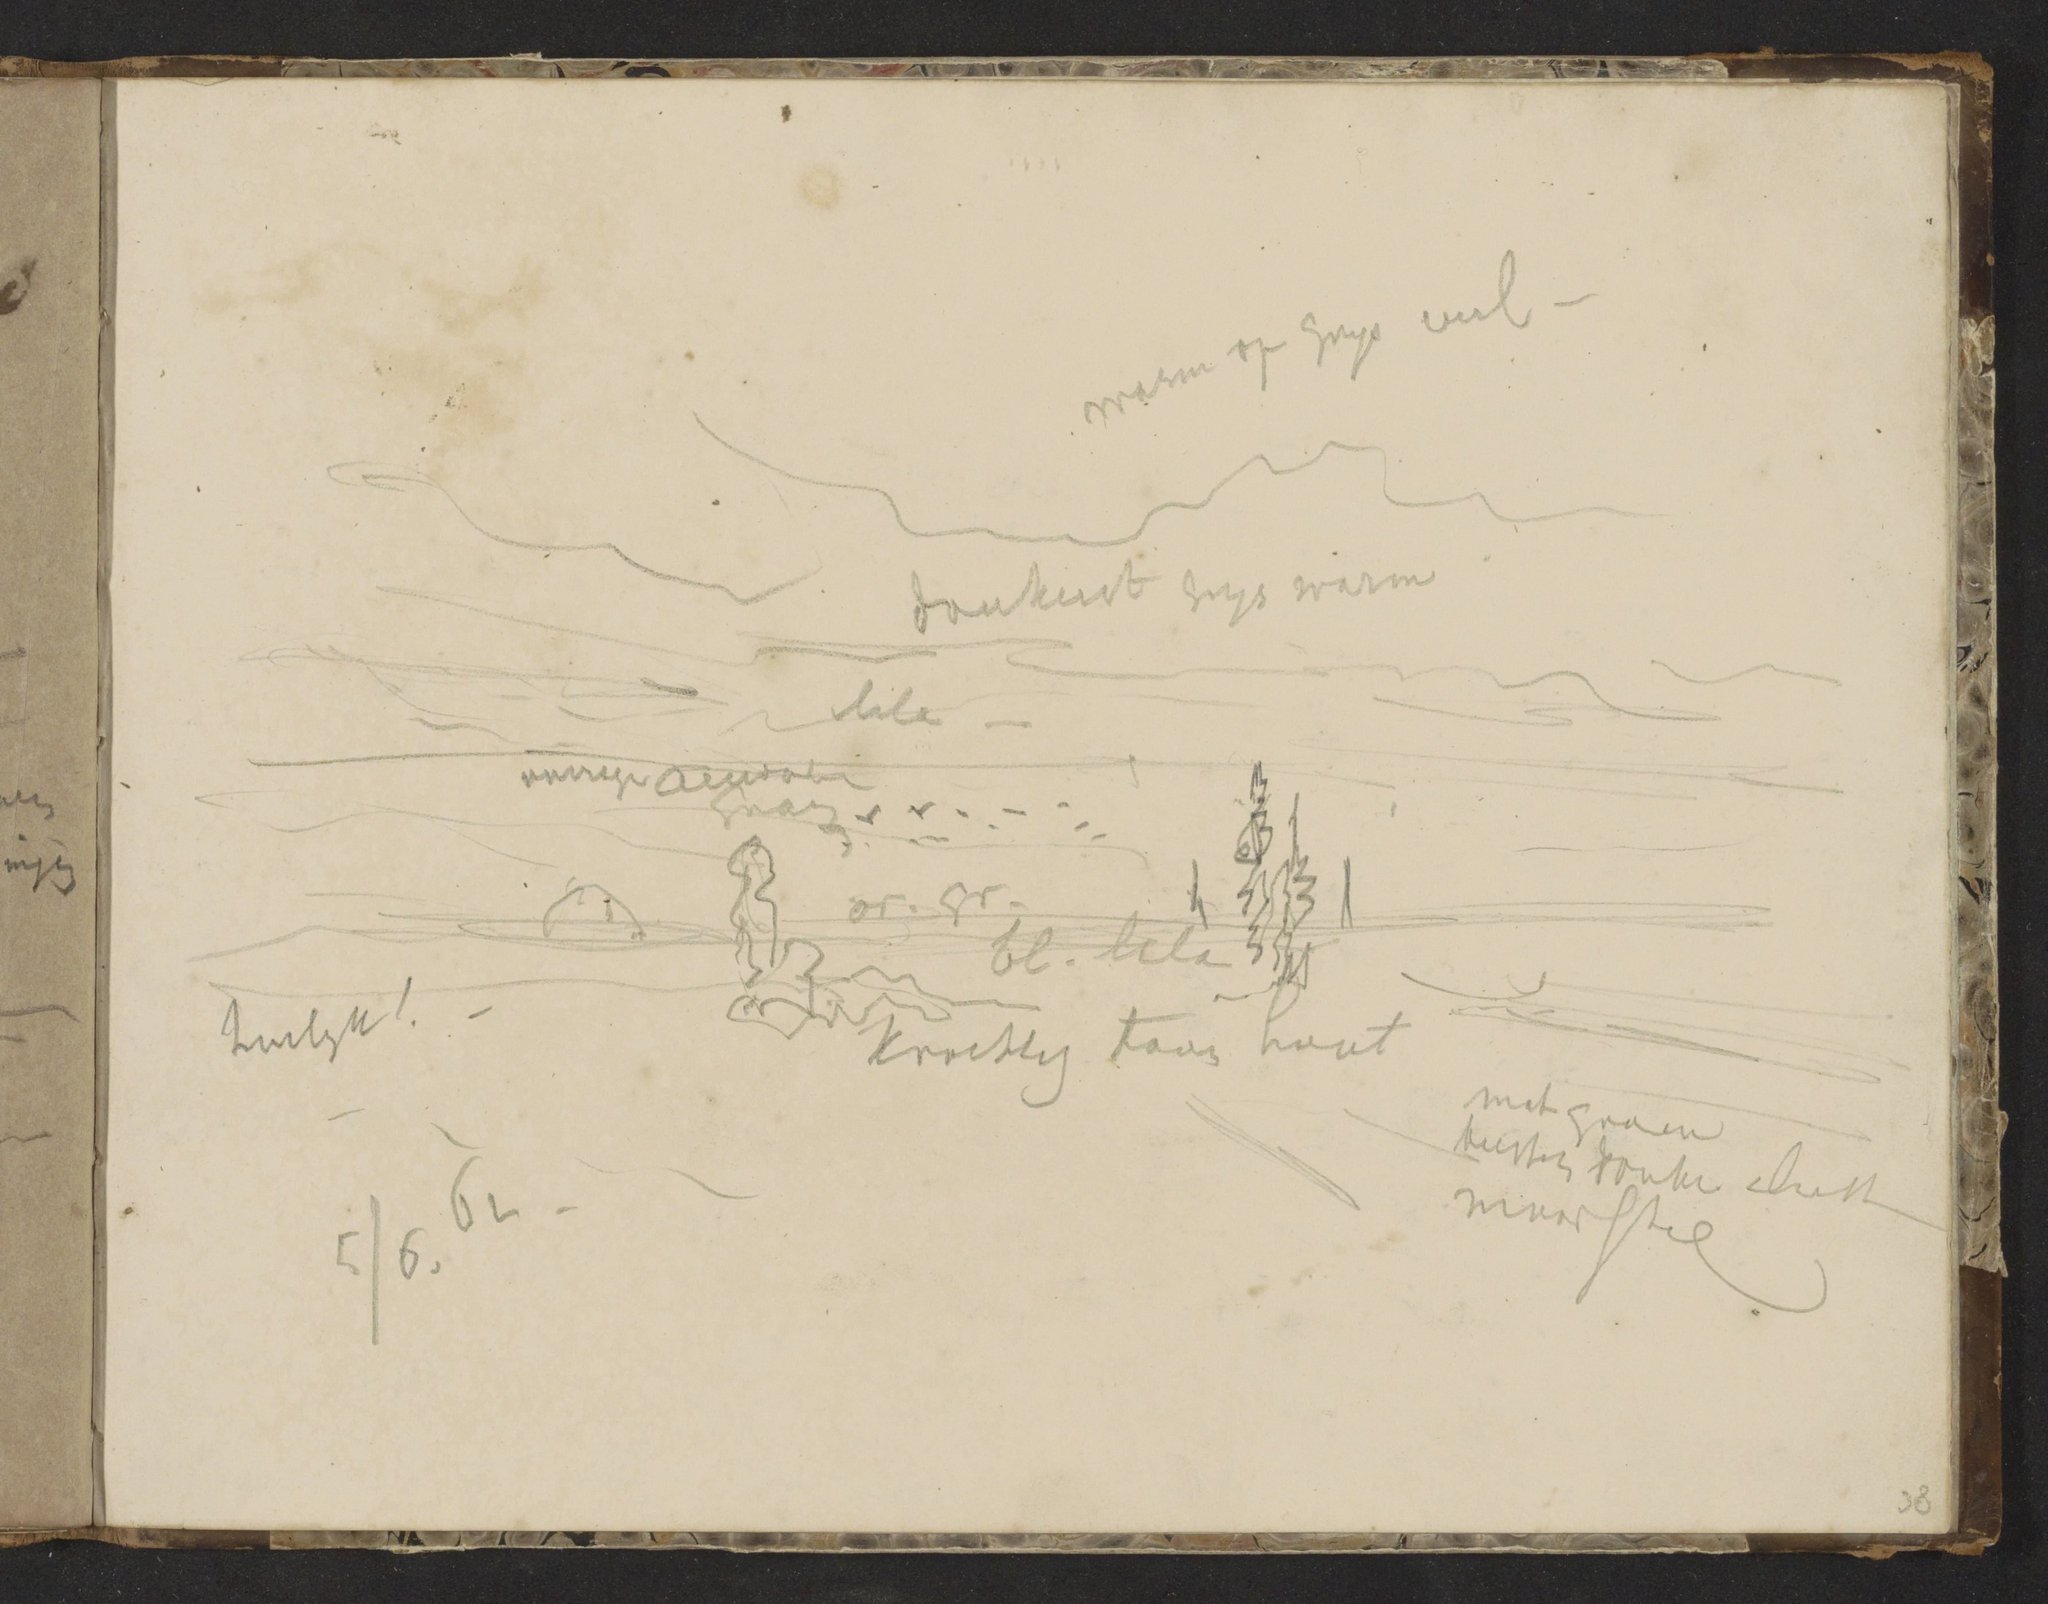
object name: sketchbook leaf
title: Landschap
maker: johannes tavenraat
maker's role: draughtsman, painter, print maker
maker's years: 1809-1881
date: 1833-1841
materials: paper, pencil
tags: landscapes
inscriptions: kleurnotitie, handgeschreven in potlood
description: Blad 38 recto uit een schetsboek met 41 bladen.